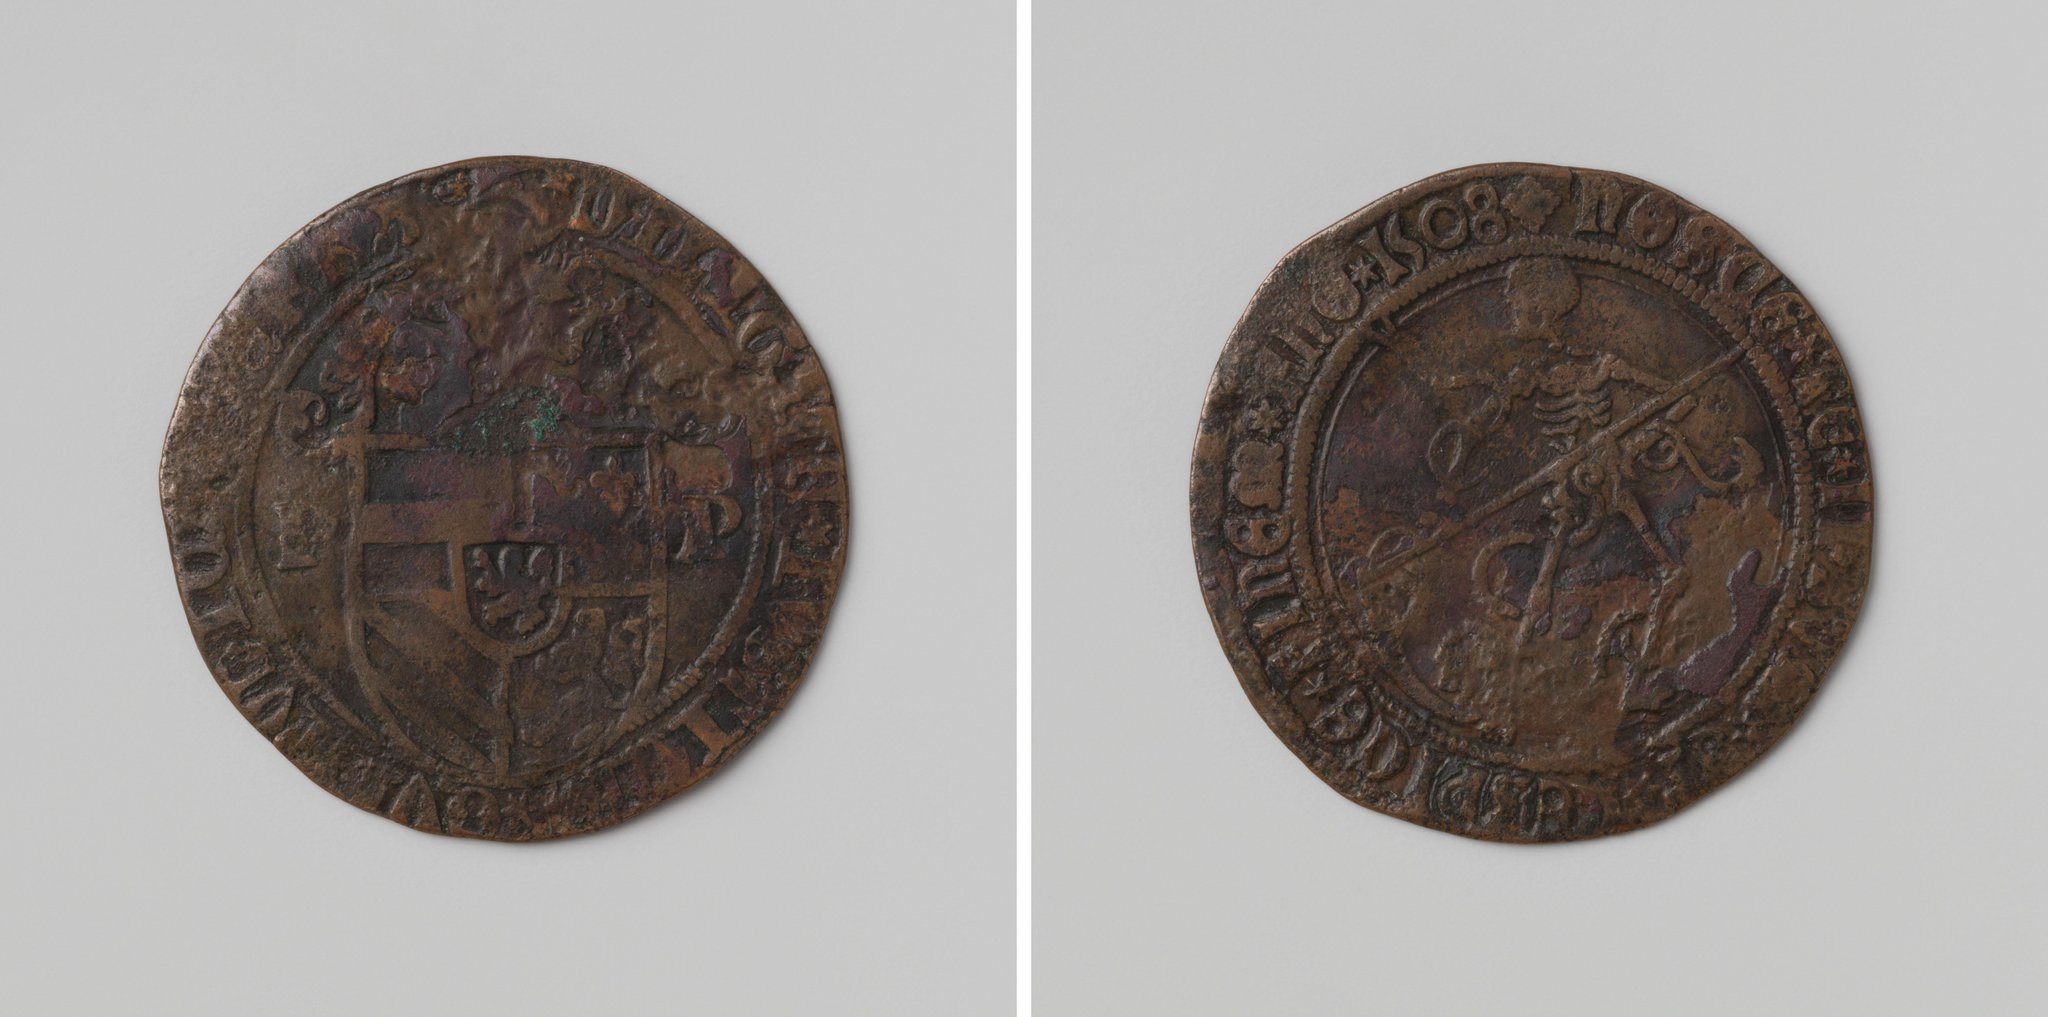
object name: jeton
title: Allegorie op de gunstige omstandigheden in de Noordelijke Nederlanden door de inname van Muiden en Weesp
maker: Anonymous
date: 1508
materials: copper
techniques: striking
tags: weesp, muiden, inname van muiden, inname van weesp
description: Koperen penning. Voorzijde: wapenschild, geflankeerd door twee letters P onder gekroonde helm binnen omschrift. Keerzijde: Dood met zeis in hand; om hem heen vier slangen binnen omschrift